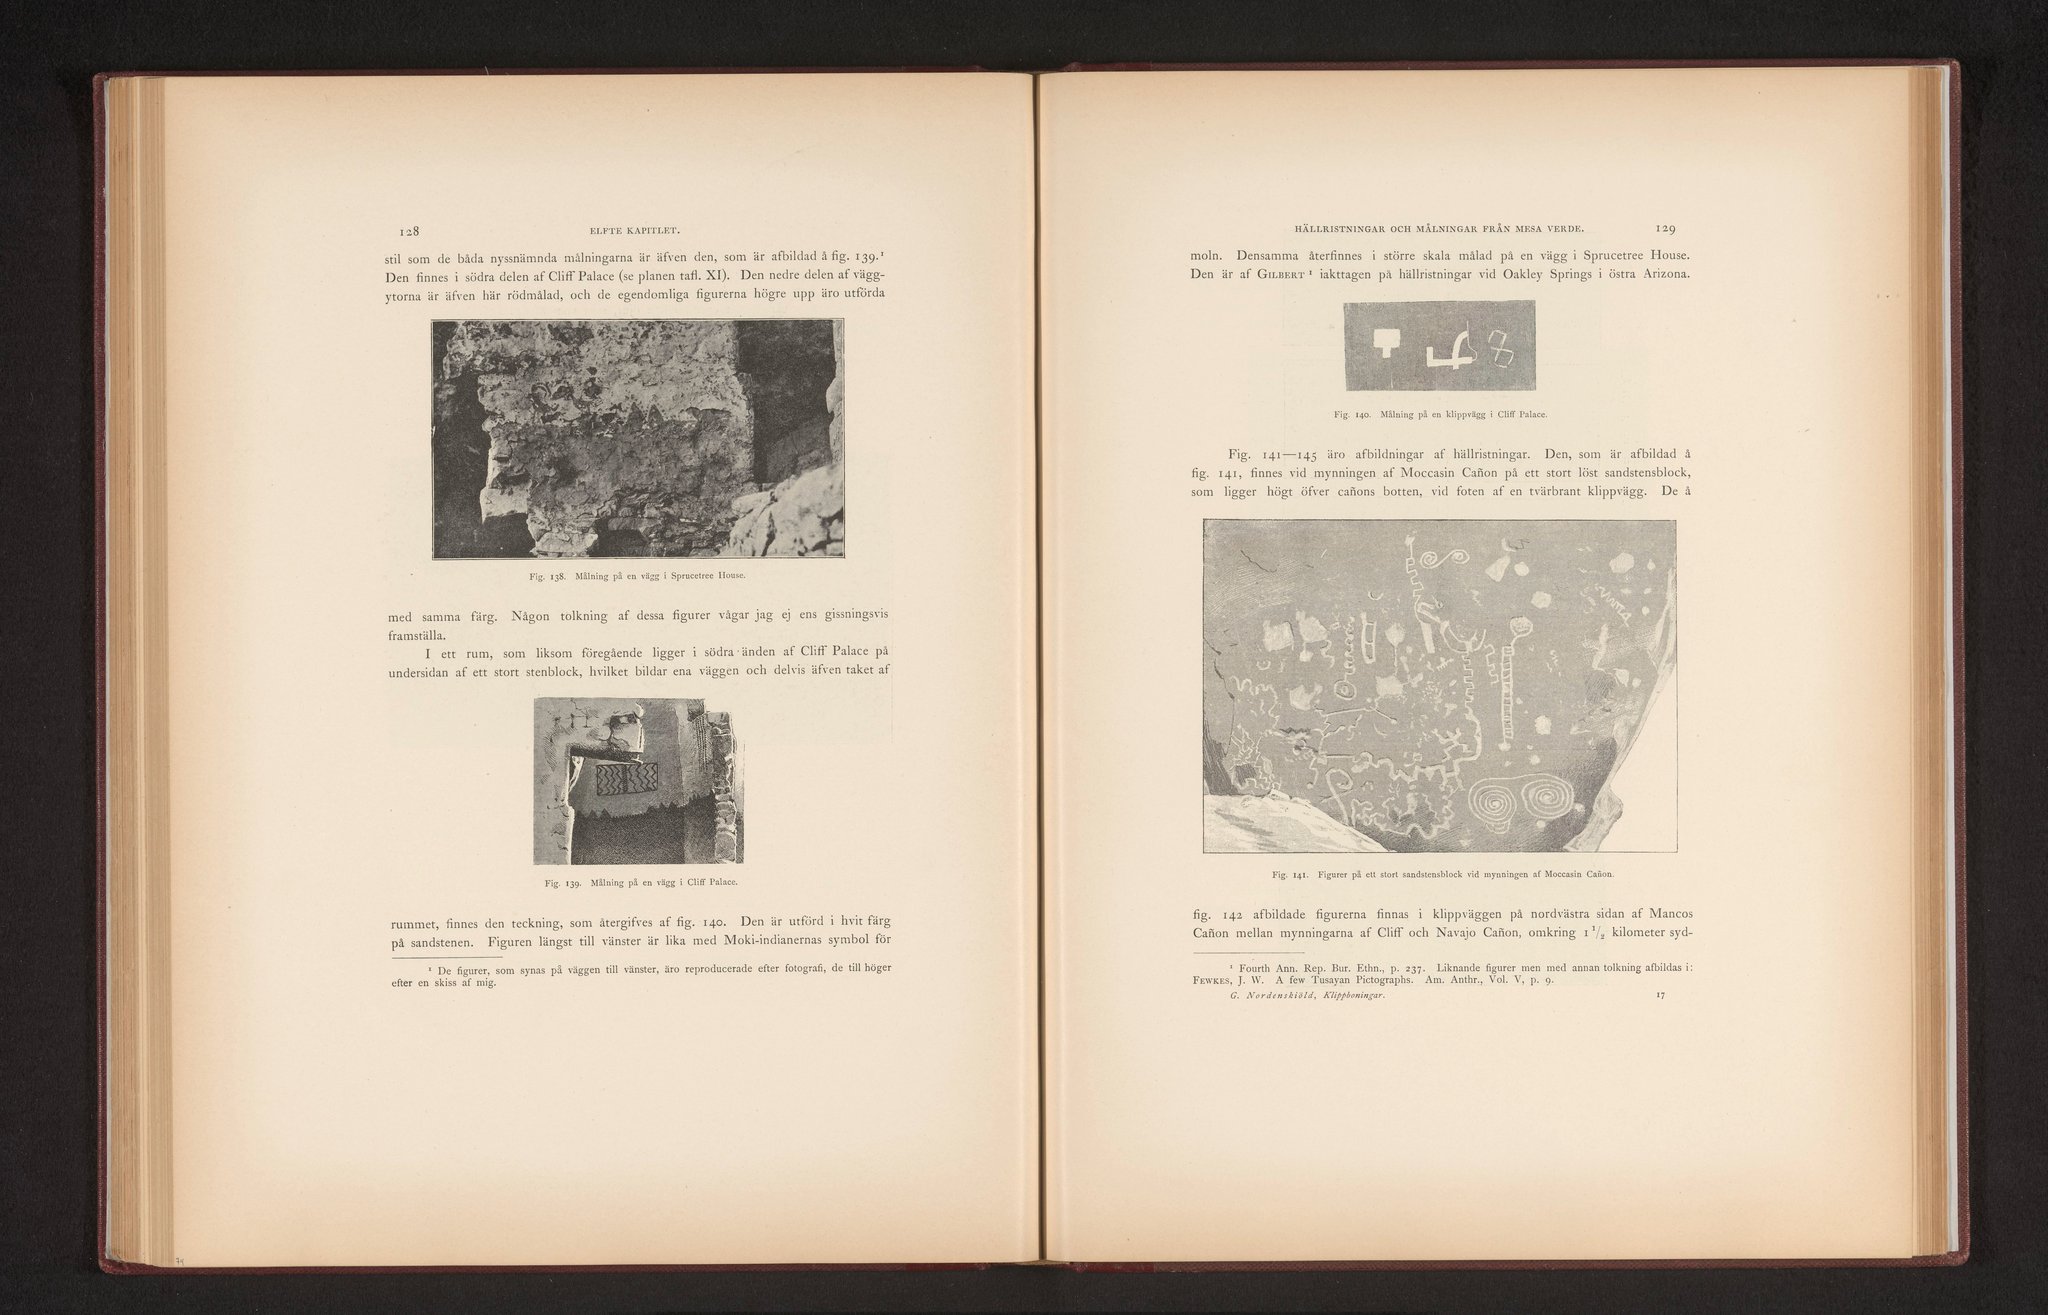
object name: photomechanical print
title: Målning på en vägg i Sprucetree House.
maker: gustaf nordenskiöld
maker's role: fotograaf, schrijver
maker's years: 1868-1895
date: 1891-1893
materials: paper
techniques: autotype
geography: vienna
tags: picture, painting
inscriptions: number: ‘Fig. 138.’